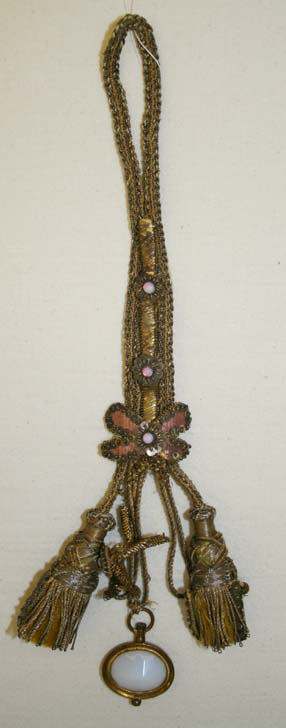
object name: fob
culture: european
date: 1767-1800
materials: glass, metal